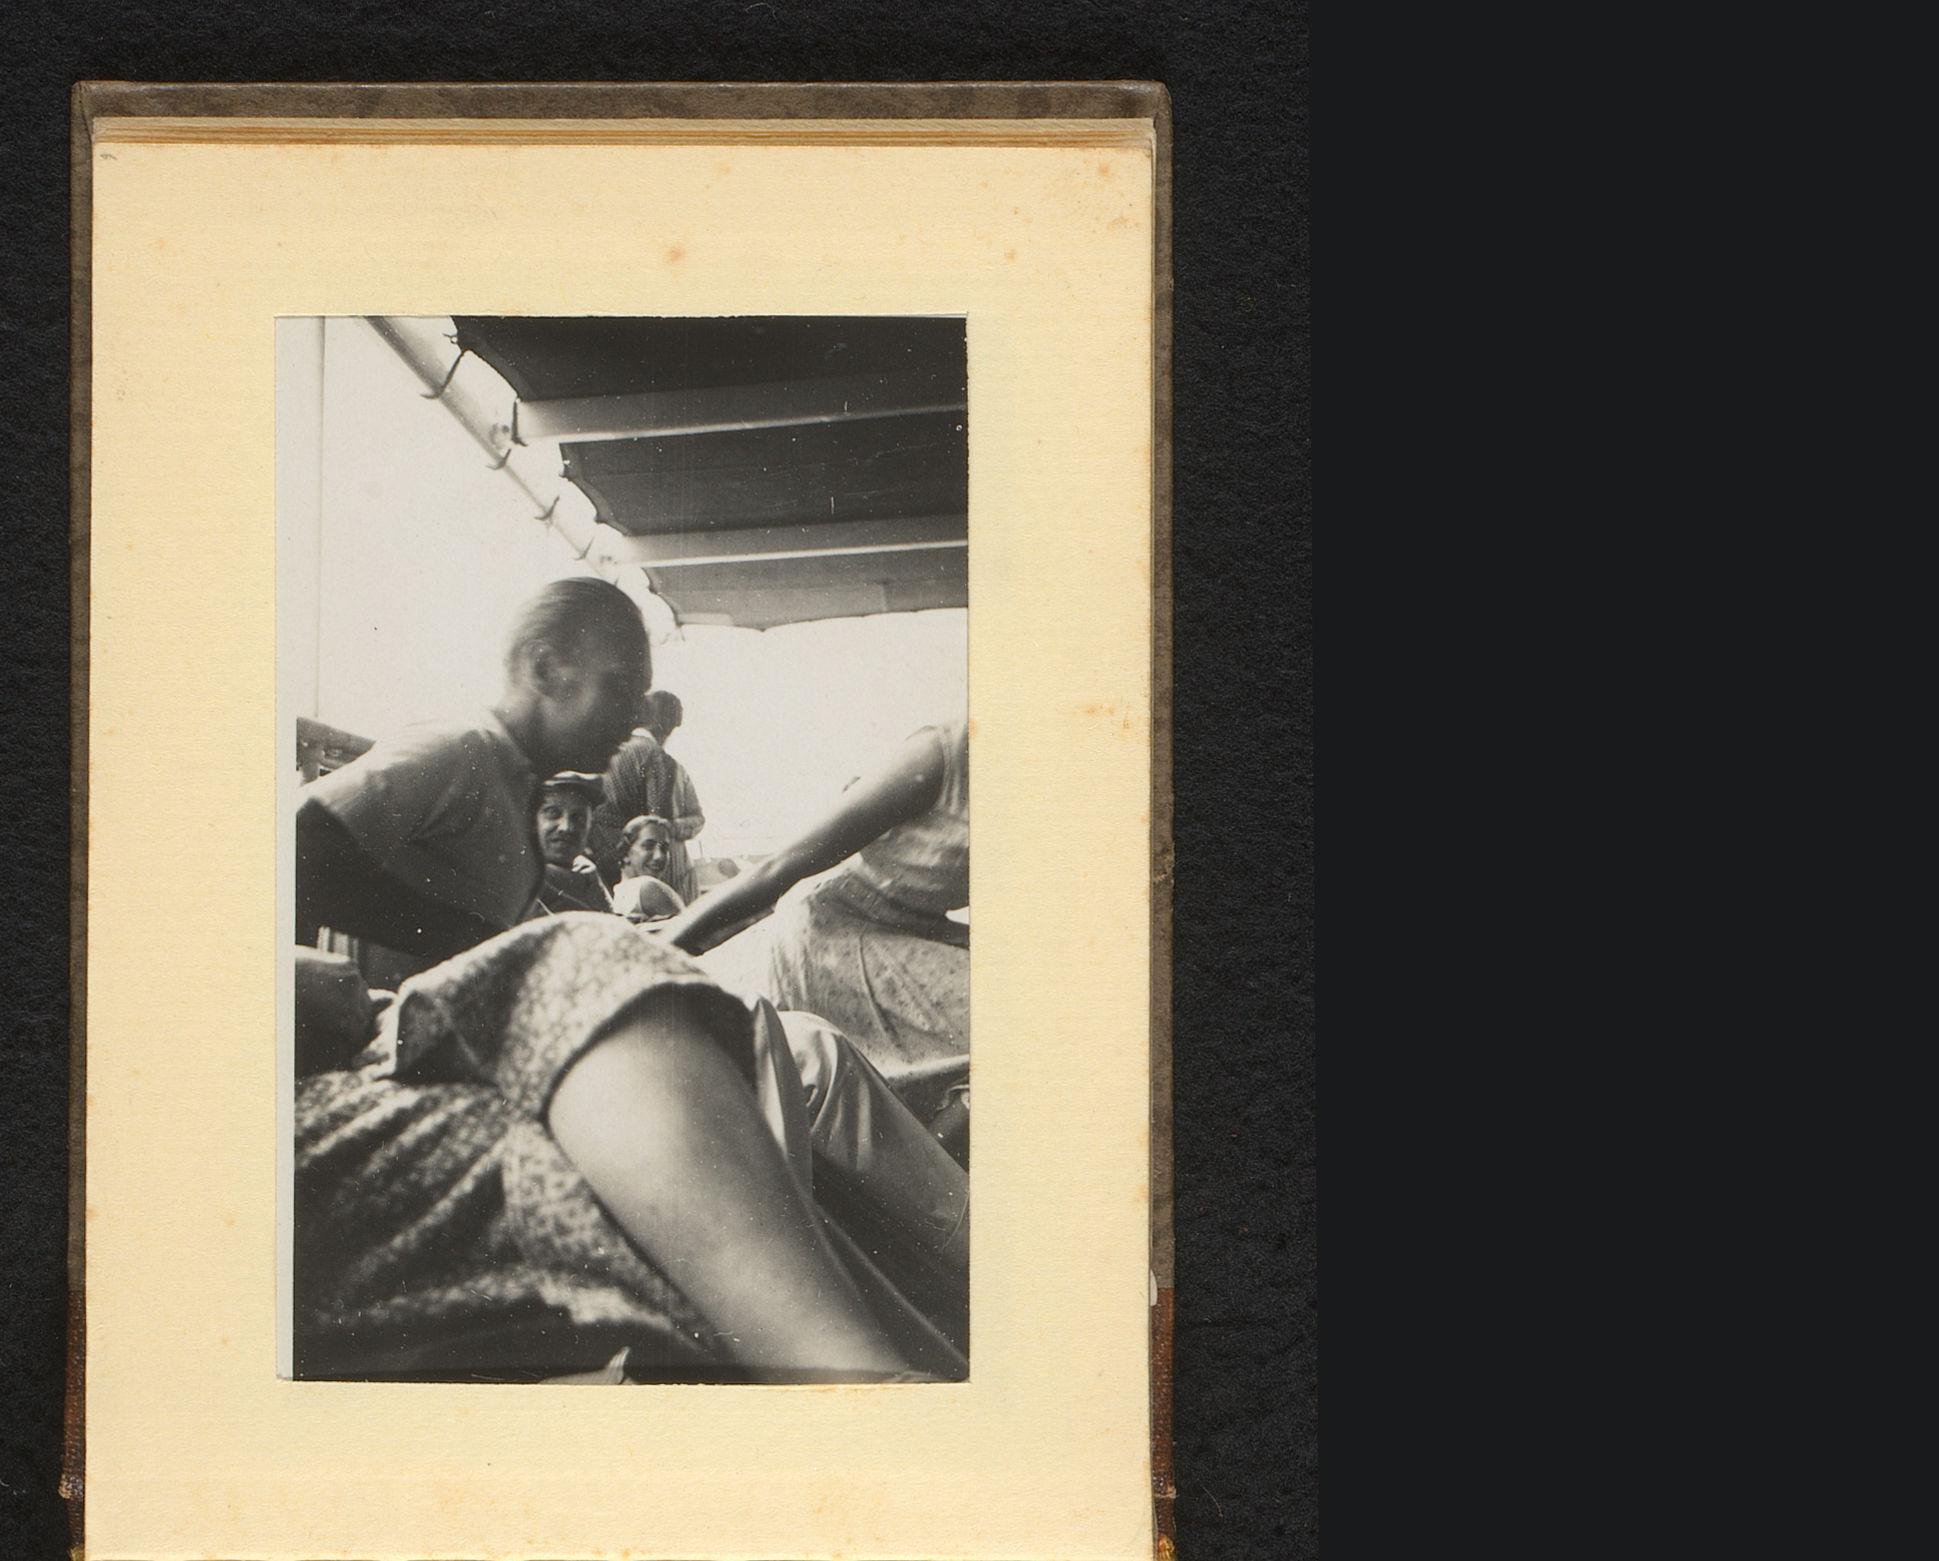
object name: photograph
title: Mensen aan boord van een schip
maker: norbert van den berg (1901-1972)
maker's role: amateurfotograaf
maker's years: 1901-1972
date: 1935-1950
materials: paper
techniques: gelatin silver print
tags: ships (in general), passengers ~ ship